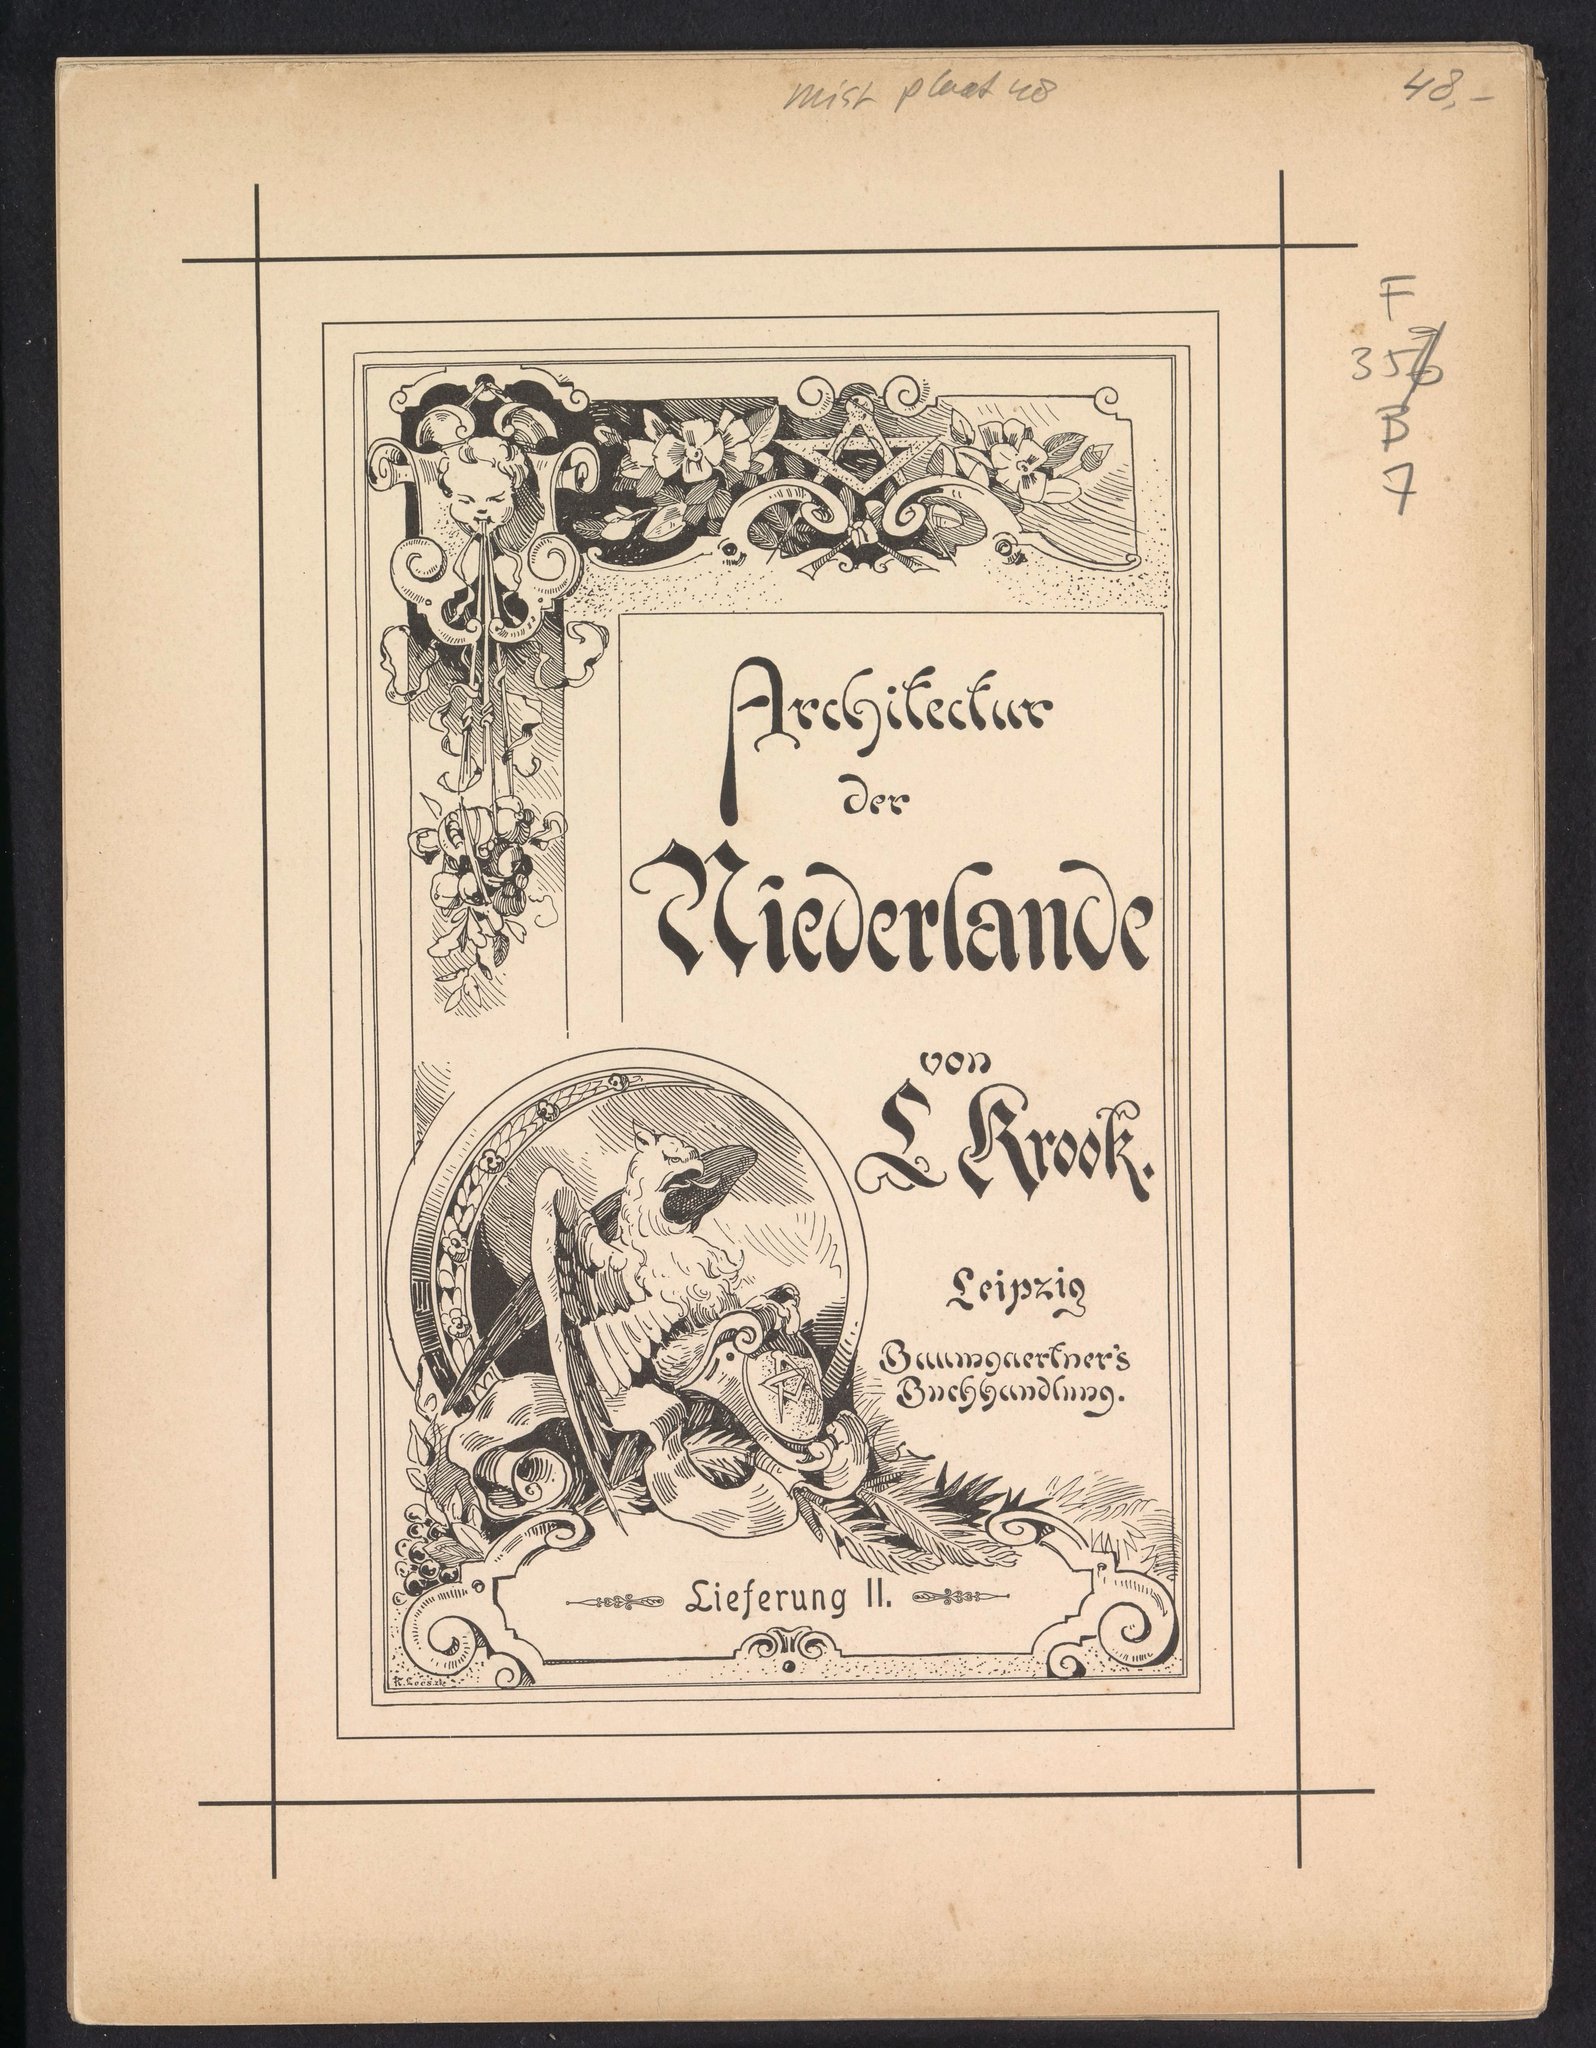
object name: book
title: Gedichte an Ihre Majestät Marie Sophie, Königin beider Sicilien geb. Herzogin in Bayern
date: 1861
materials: cardboard, paper, photographic support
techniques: albumen print, printing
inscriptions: bookplate: ‘Friedrich Treyherr Gross von Trockau’